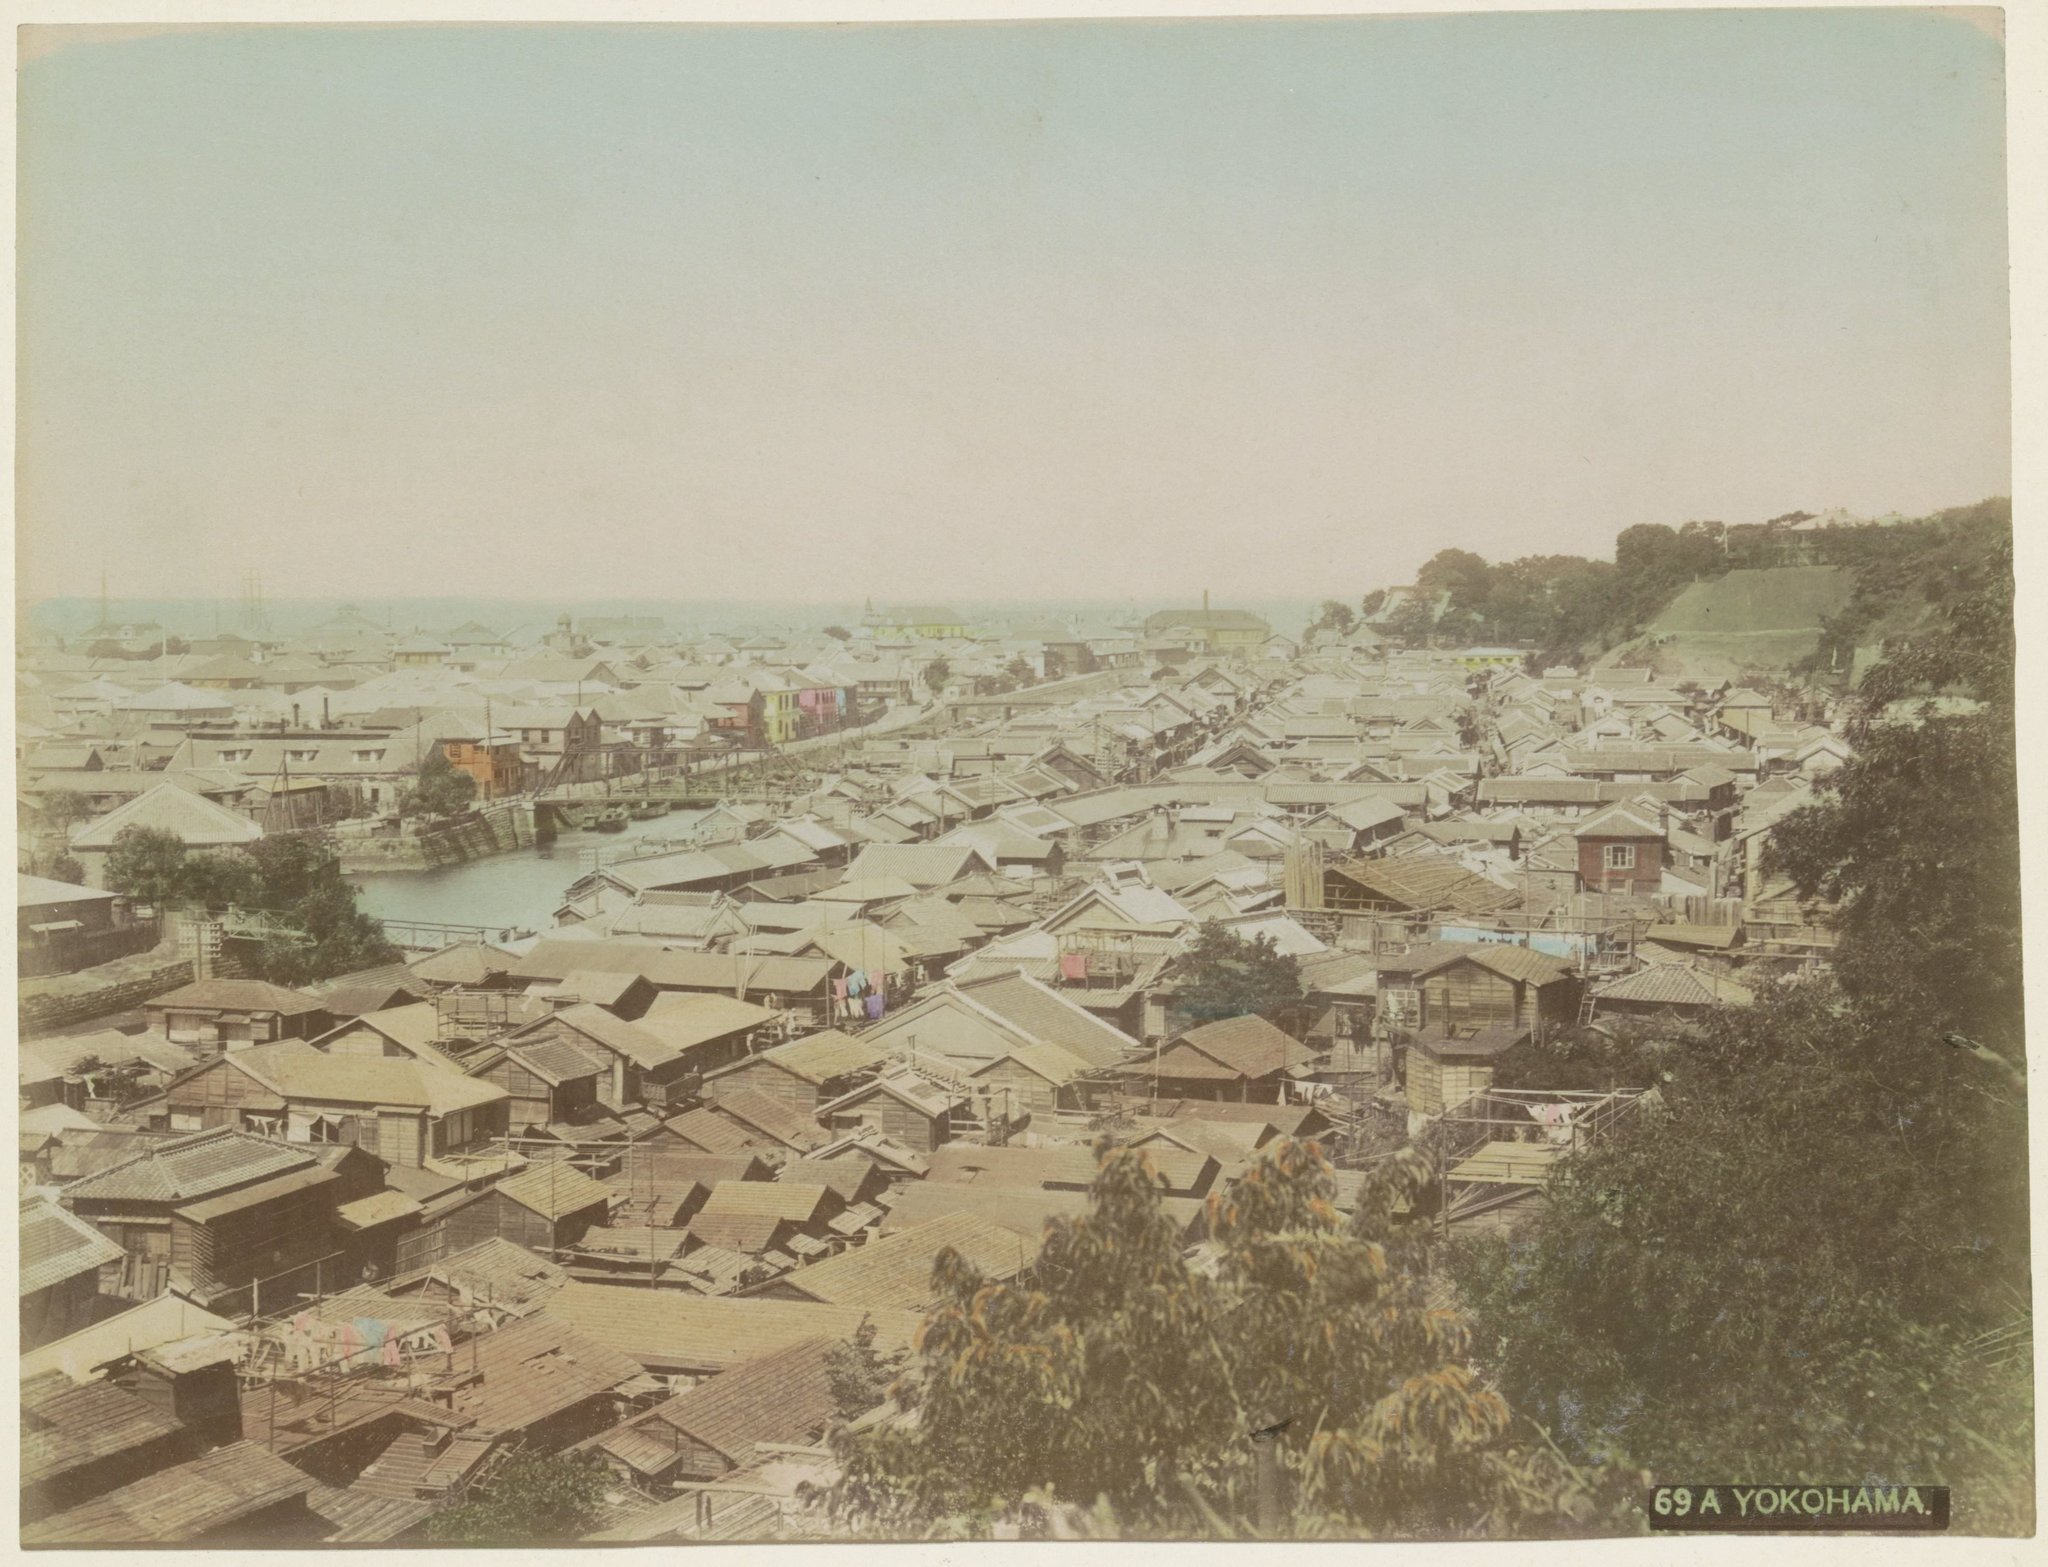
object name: photograph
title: Gezicht op Yokohama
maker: Anonymous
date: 1870-1900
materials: cardboard, paper, photographic support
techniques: albumen print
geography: yokohama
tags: prospect of village, silhouette of village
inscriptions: negative number: ‘69 A’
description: Onderdeel van Reisalbum met foto's van bezienswaardigheden in Japan.